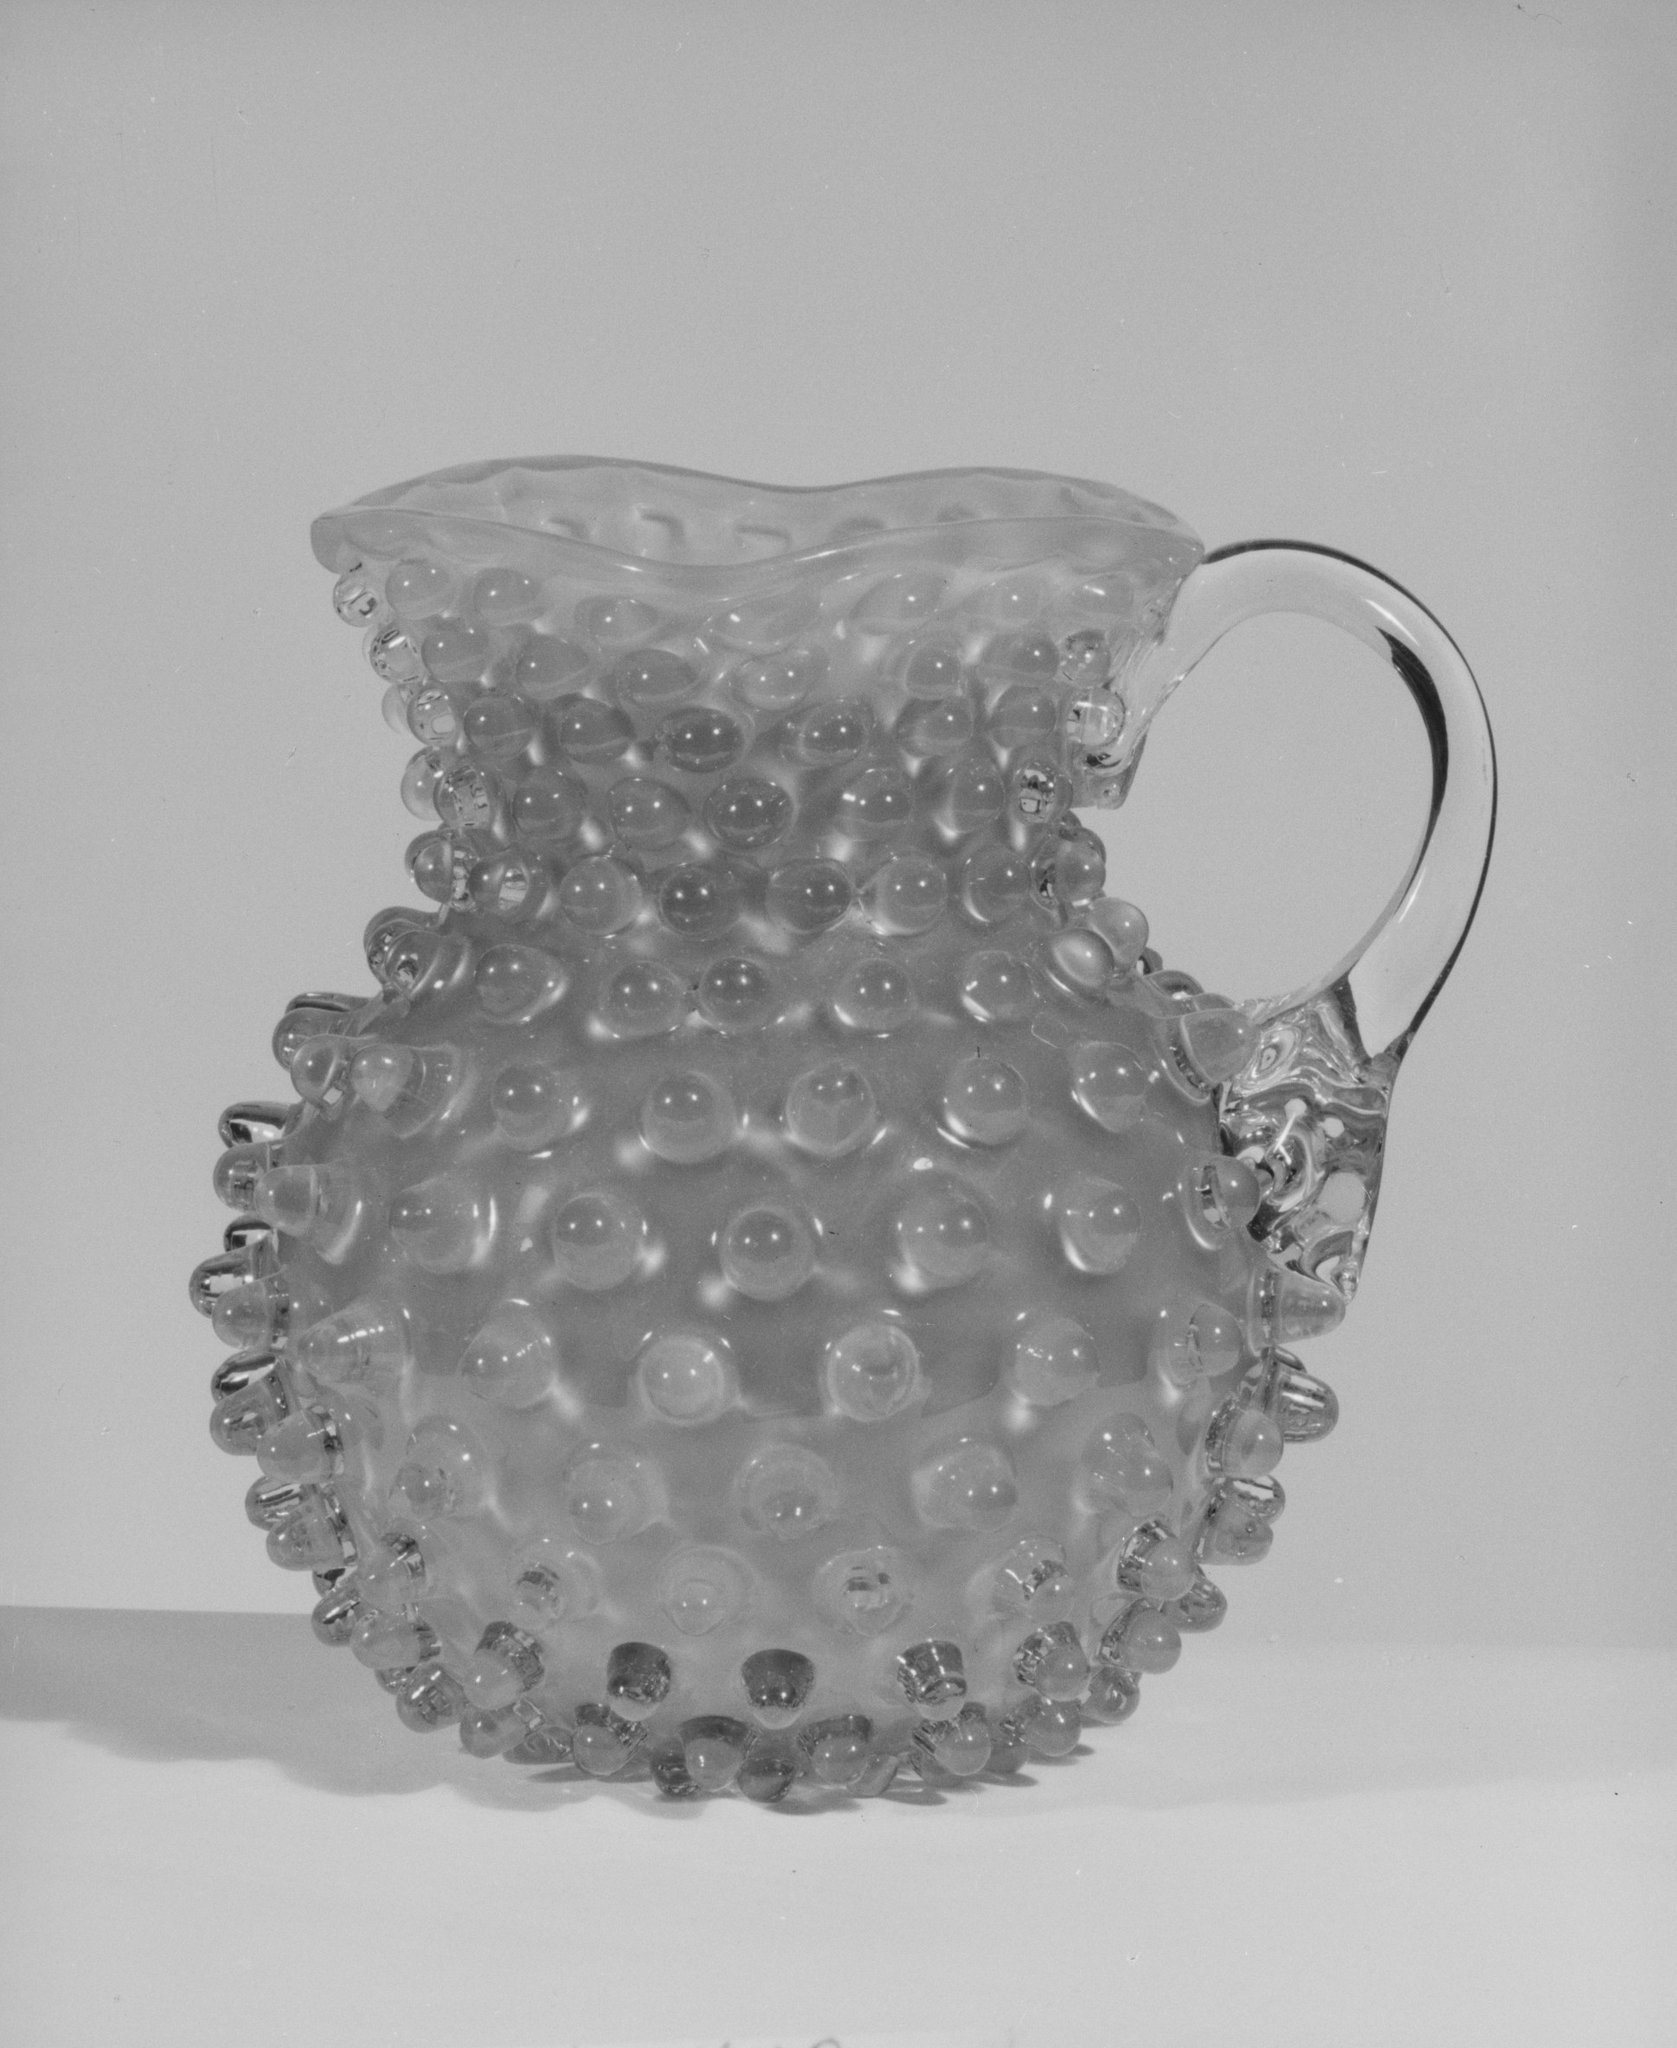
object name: cream pot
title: Hobnail Creamer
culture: american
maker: hobbs, brockunier and company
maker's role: maker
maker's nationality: american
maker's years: 1863-1891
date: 1886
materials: glass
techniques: pressed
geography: united states